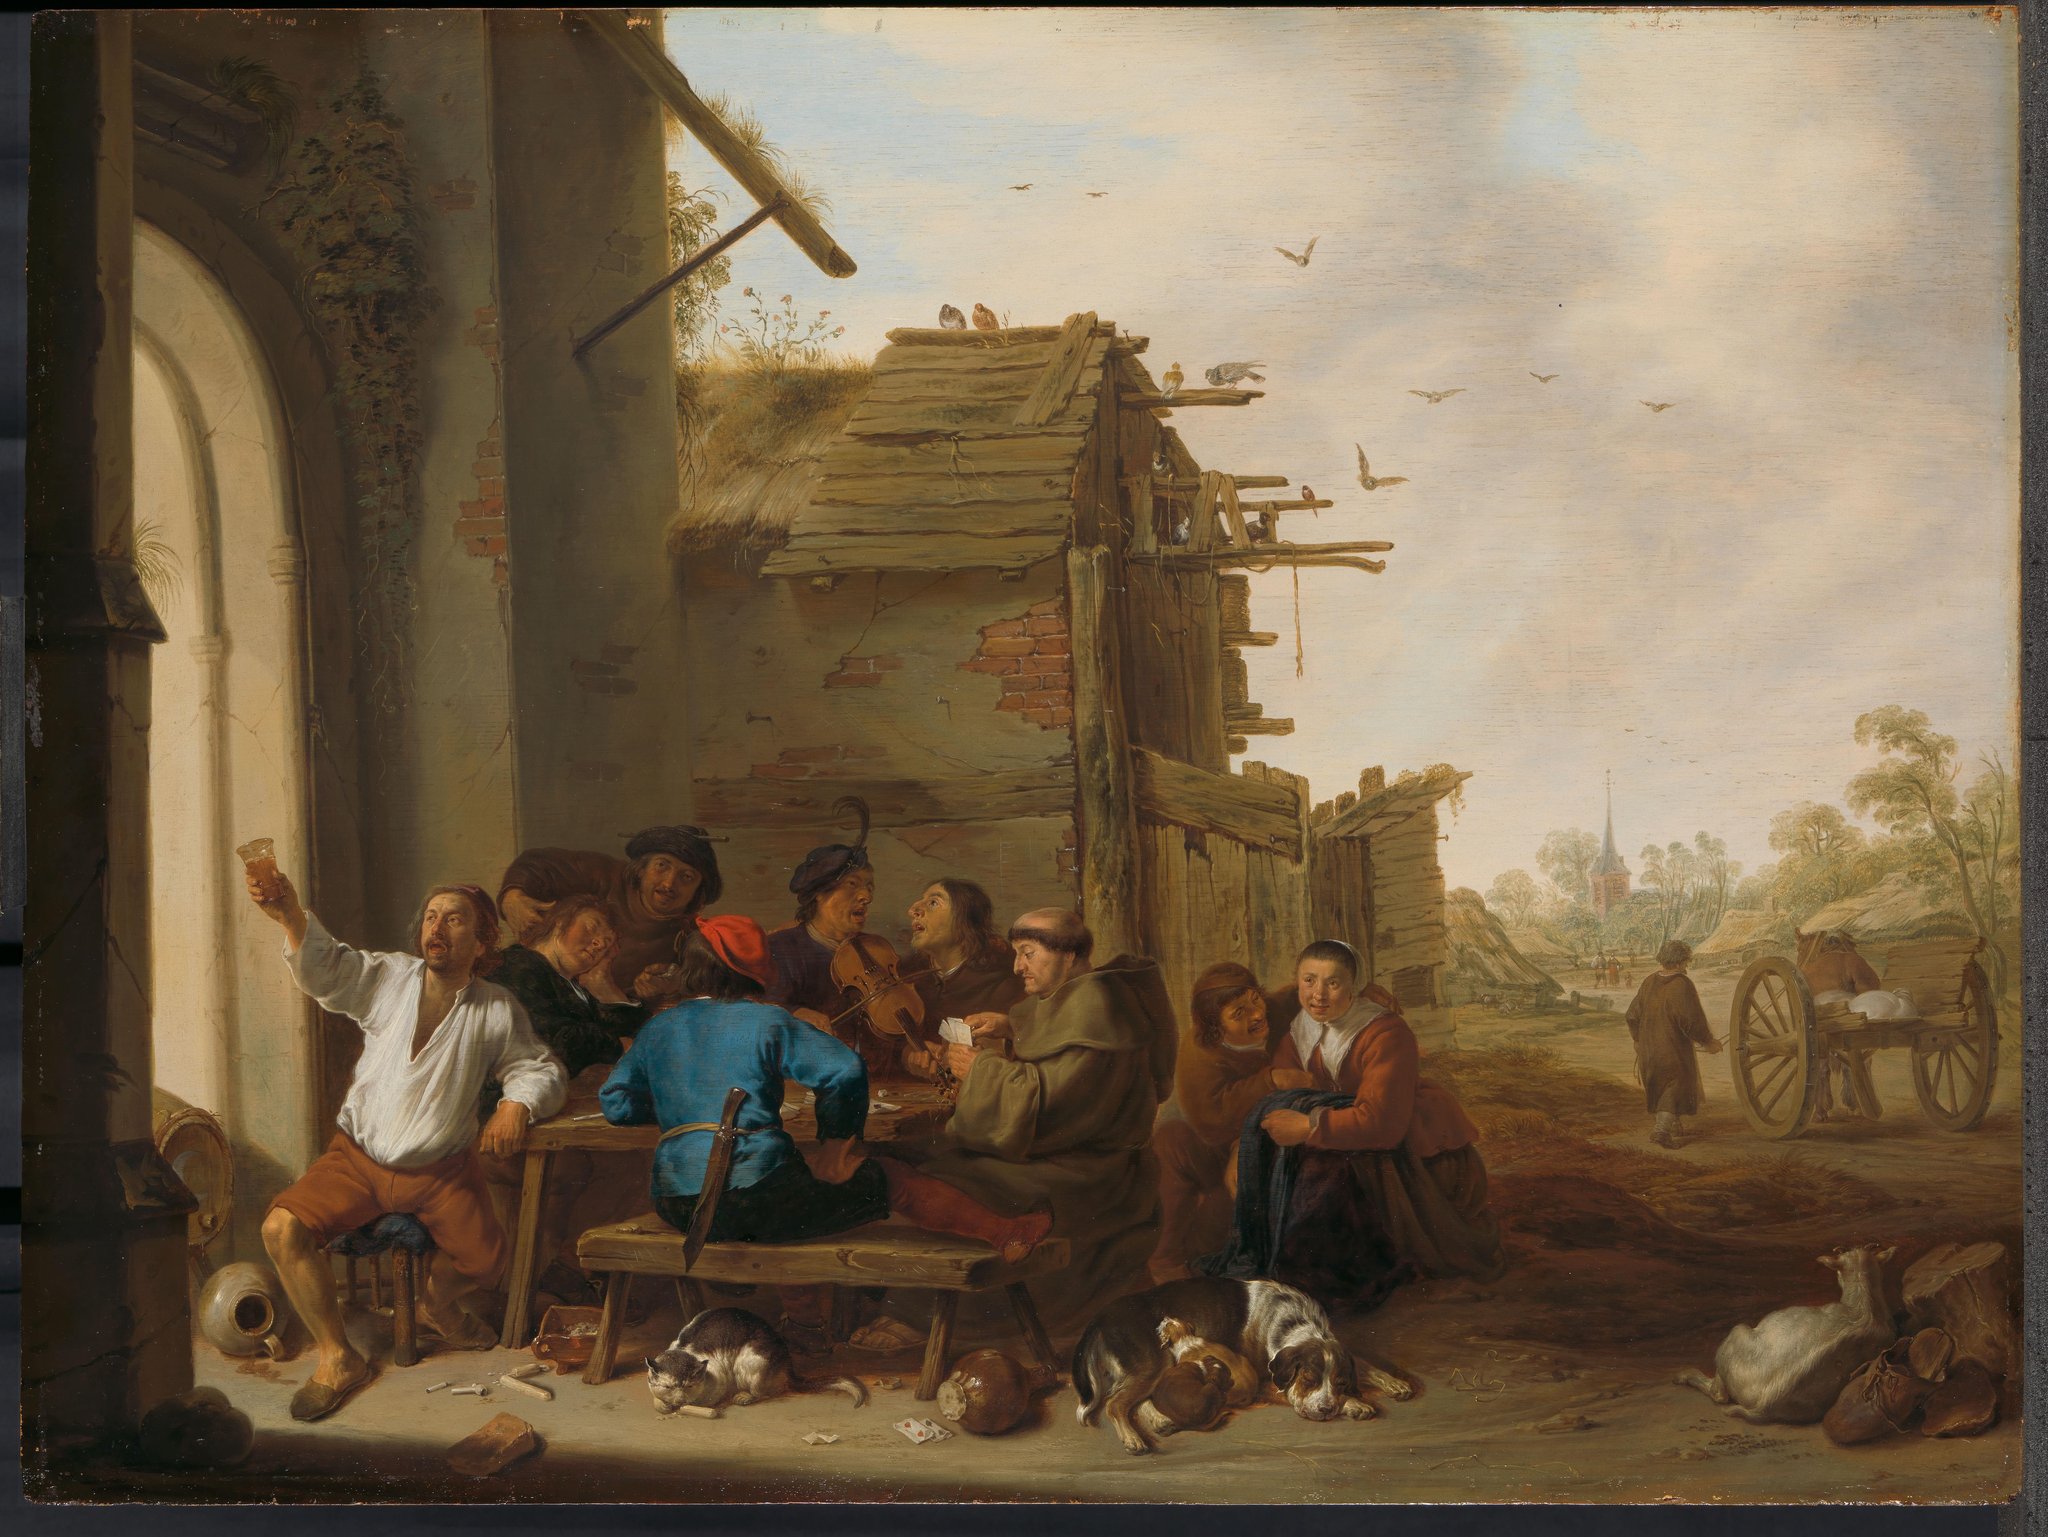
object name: painting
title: A Company of Country Folk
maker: cornelis saftleven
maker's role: draughtsman, painter, print maker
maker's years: 1607-1681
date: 1642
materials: oil, panel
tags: farmers, violin, fiddle - cc - out of doors, card games, dog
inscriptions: signature and date, lower left, on the base of the pilaster: ‘C / Saft / Leven / 1642’, signature, with monogram, on the reverse (S and L ligated): ‘C SL’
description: A storm is brewing. The man at the left has clearly already had too much to drink yet is ordering more. The dangerous dagger of the man in blue signals trouble. The couple at the right makes love half-heartedly. And the portly mendicant friar absorbed in his card game … did he not take a vow of poverty? This will not end well.